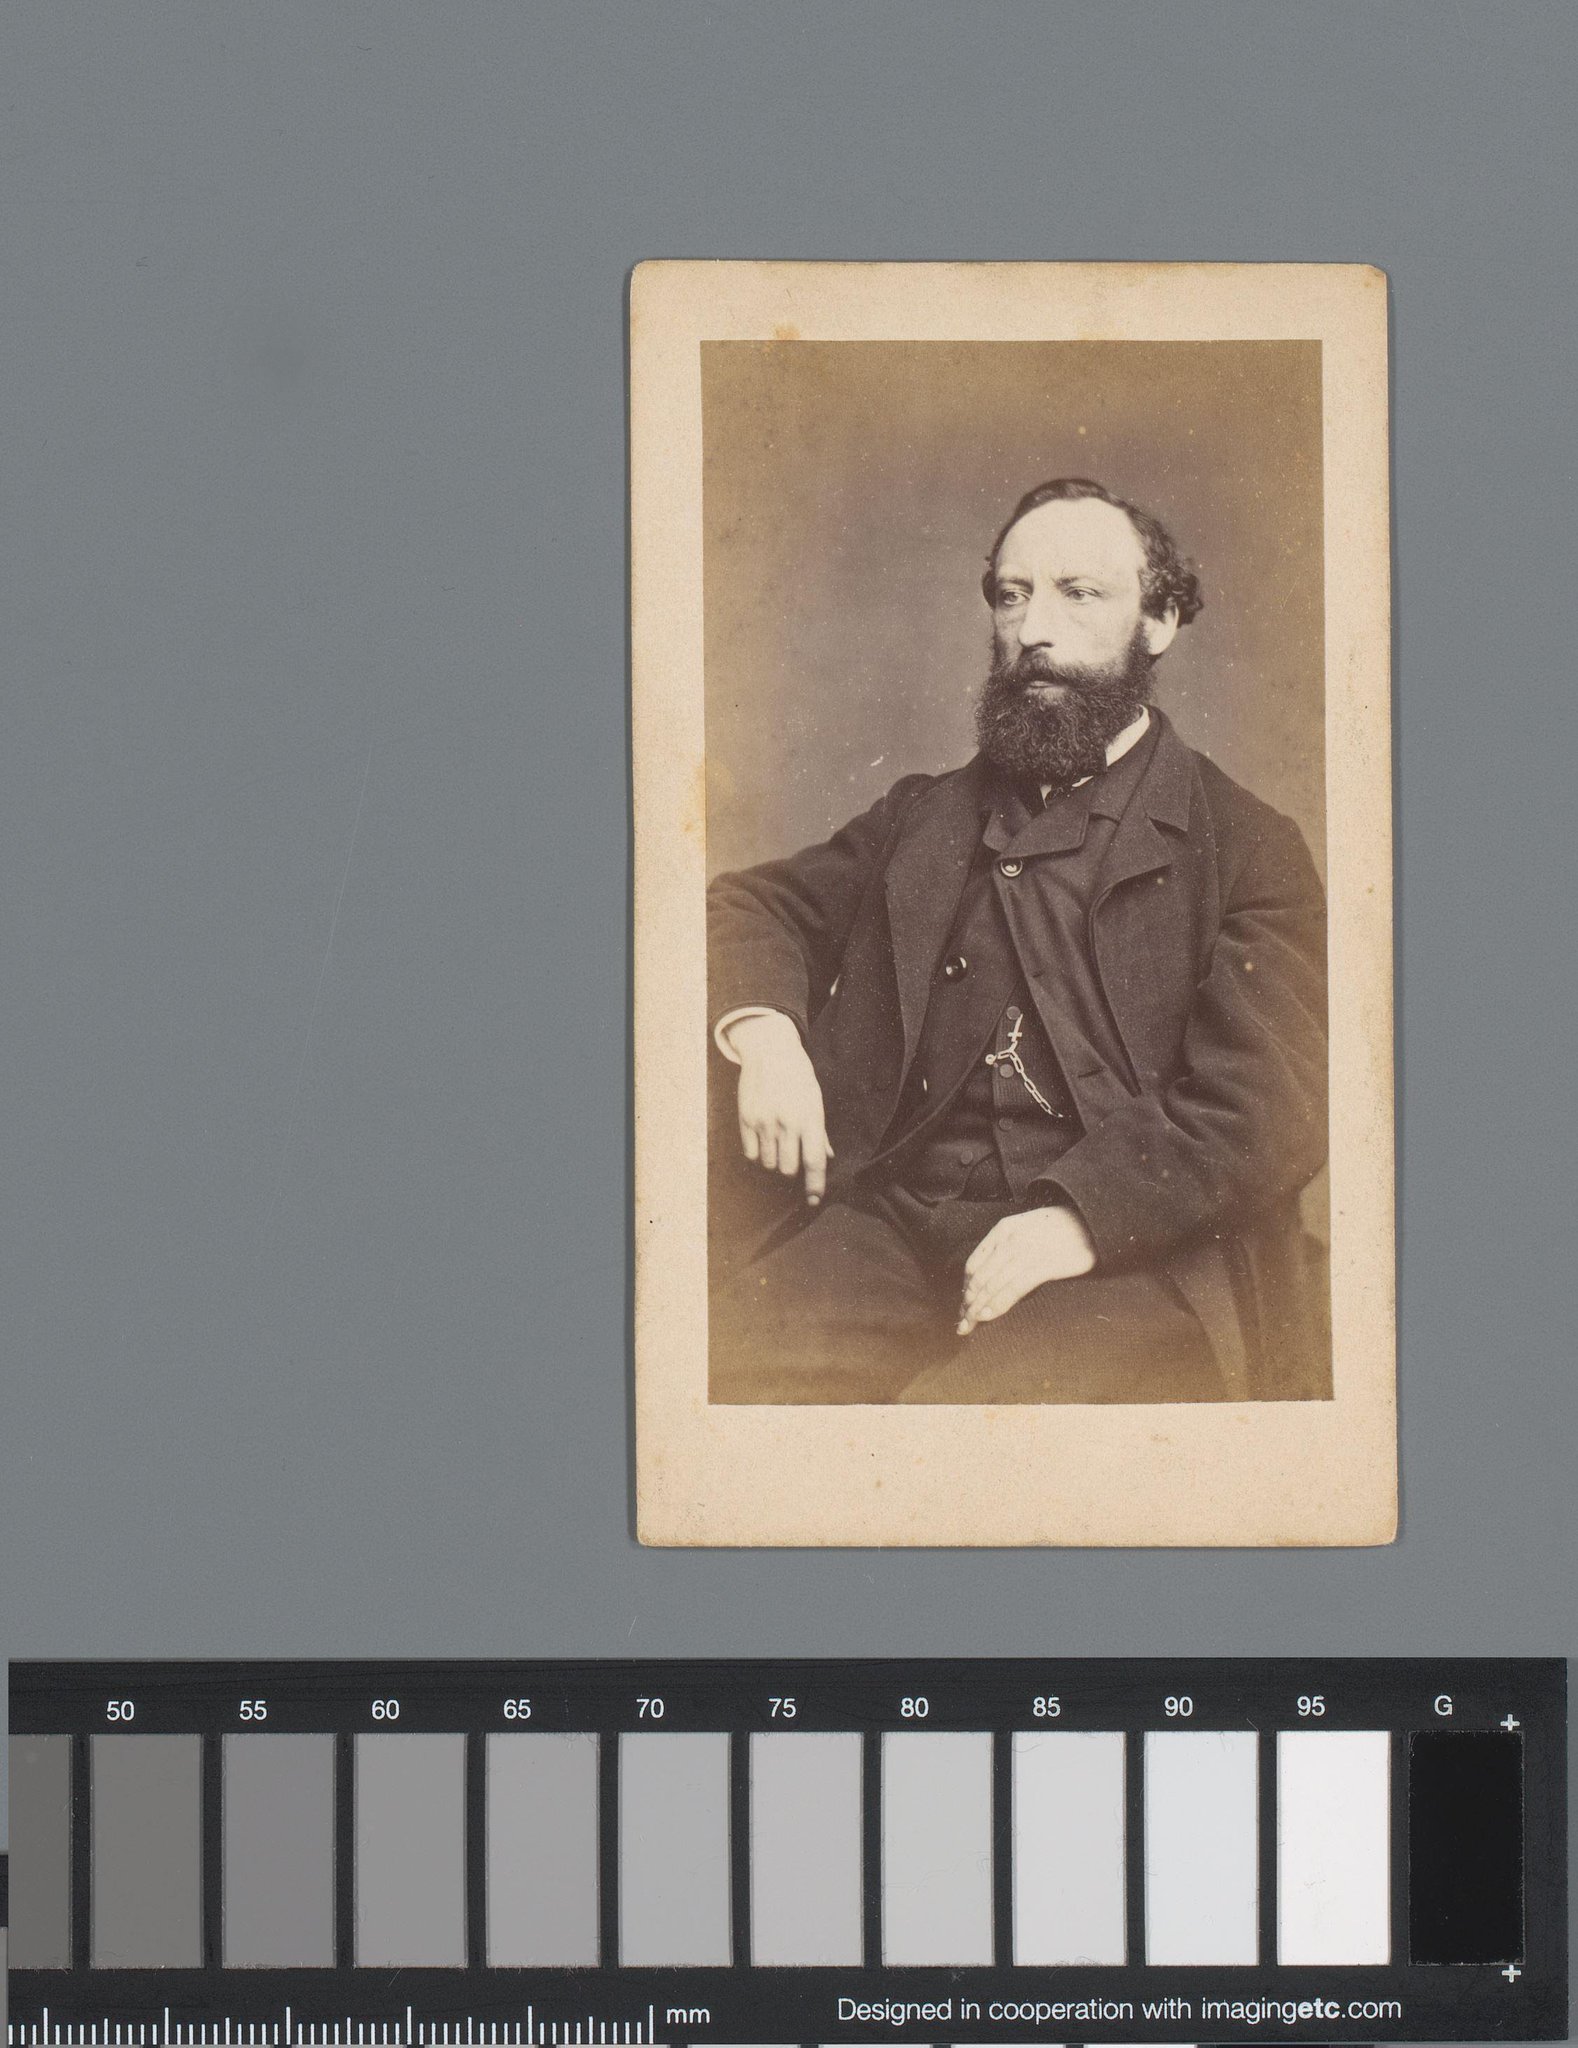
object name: carte de visite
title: Portret van de schilder Louis Hendrix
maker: Anonymous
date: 1866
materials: cardboard, paper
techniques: albumen print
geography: belgium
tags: antwerp, painter, historical persons, portrait, self-portrait of painter, belgium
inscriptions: inscription: ‘Louis Hendrix (peintre)/ 1866’